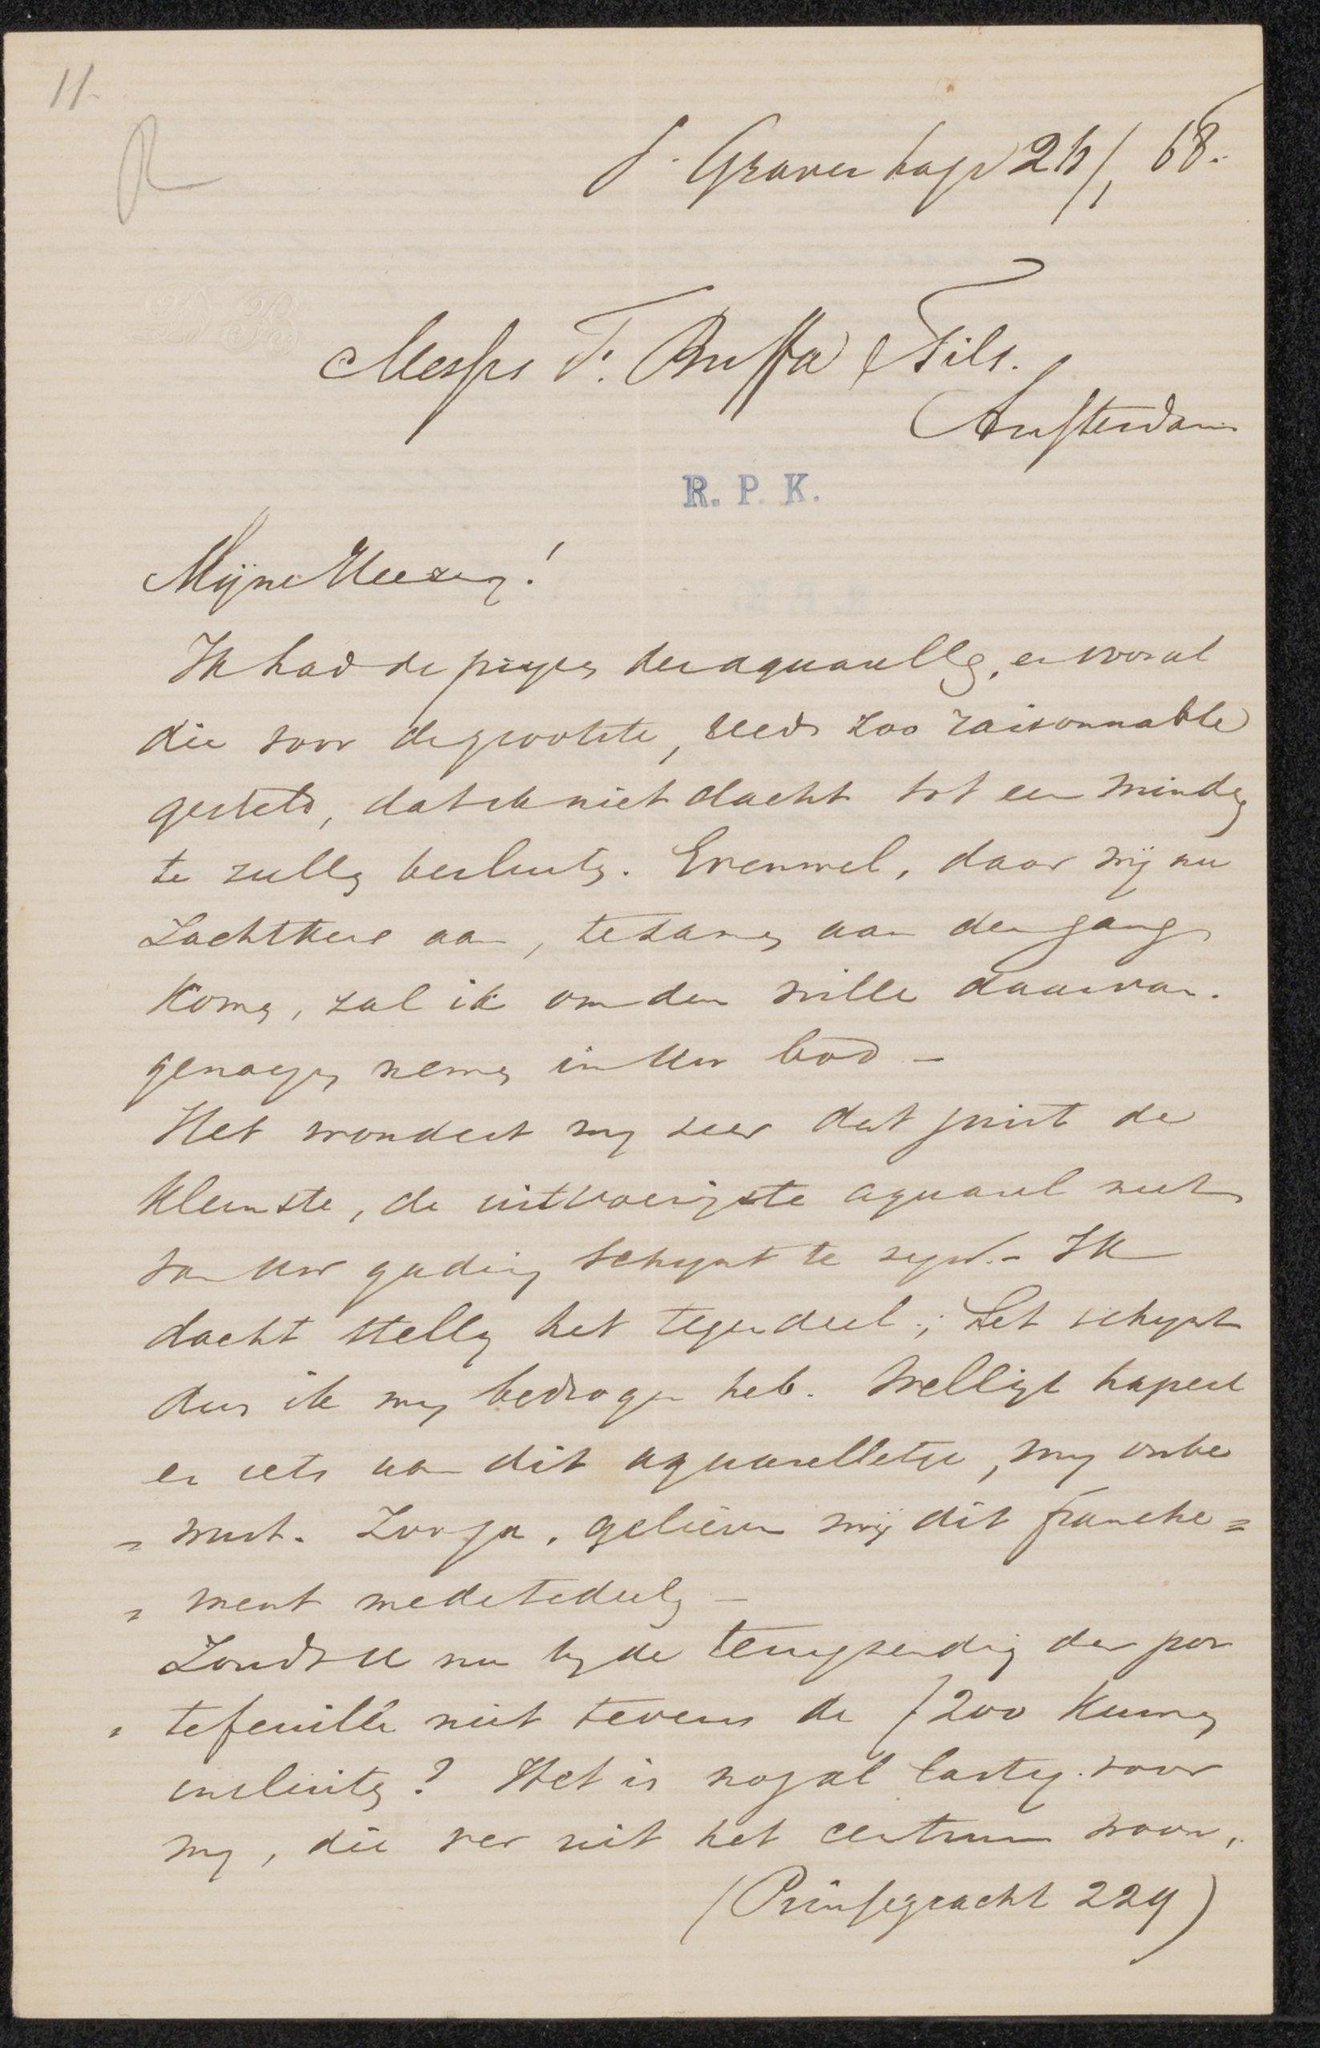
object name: letter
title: Brief aan Frans Buffa en Zonen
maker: david bles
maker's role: draughtsman, painter, print maker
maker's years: 1821-1899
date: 1868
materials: ink, paper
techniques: pen, writing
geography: the hague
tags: publisher, drawing, money, the hague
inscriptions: collector's mark: Lugt 2233, monogram: ‘DB’